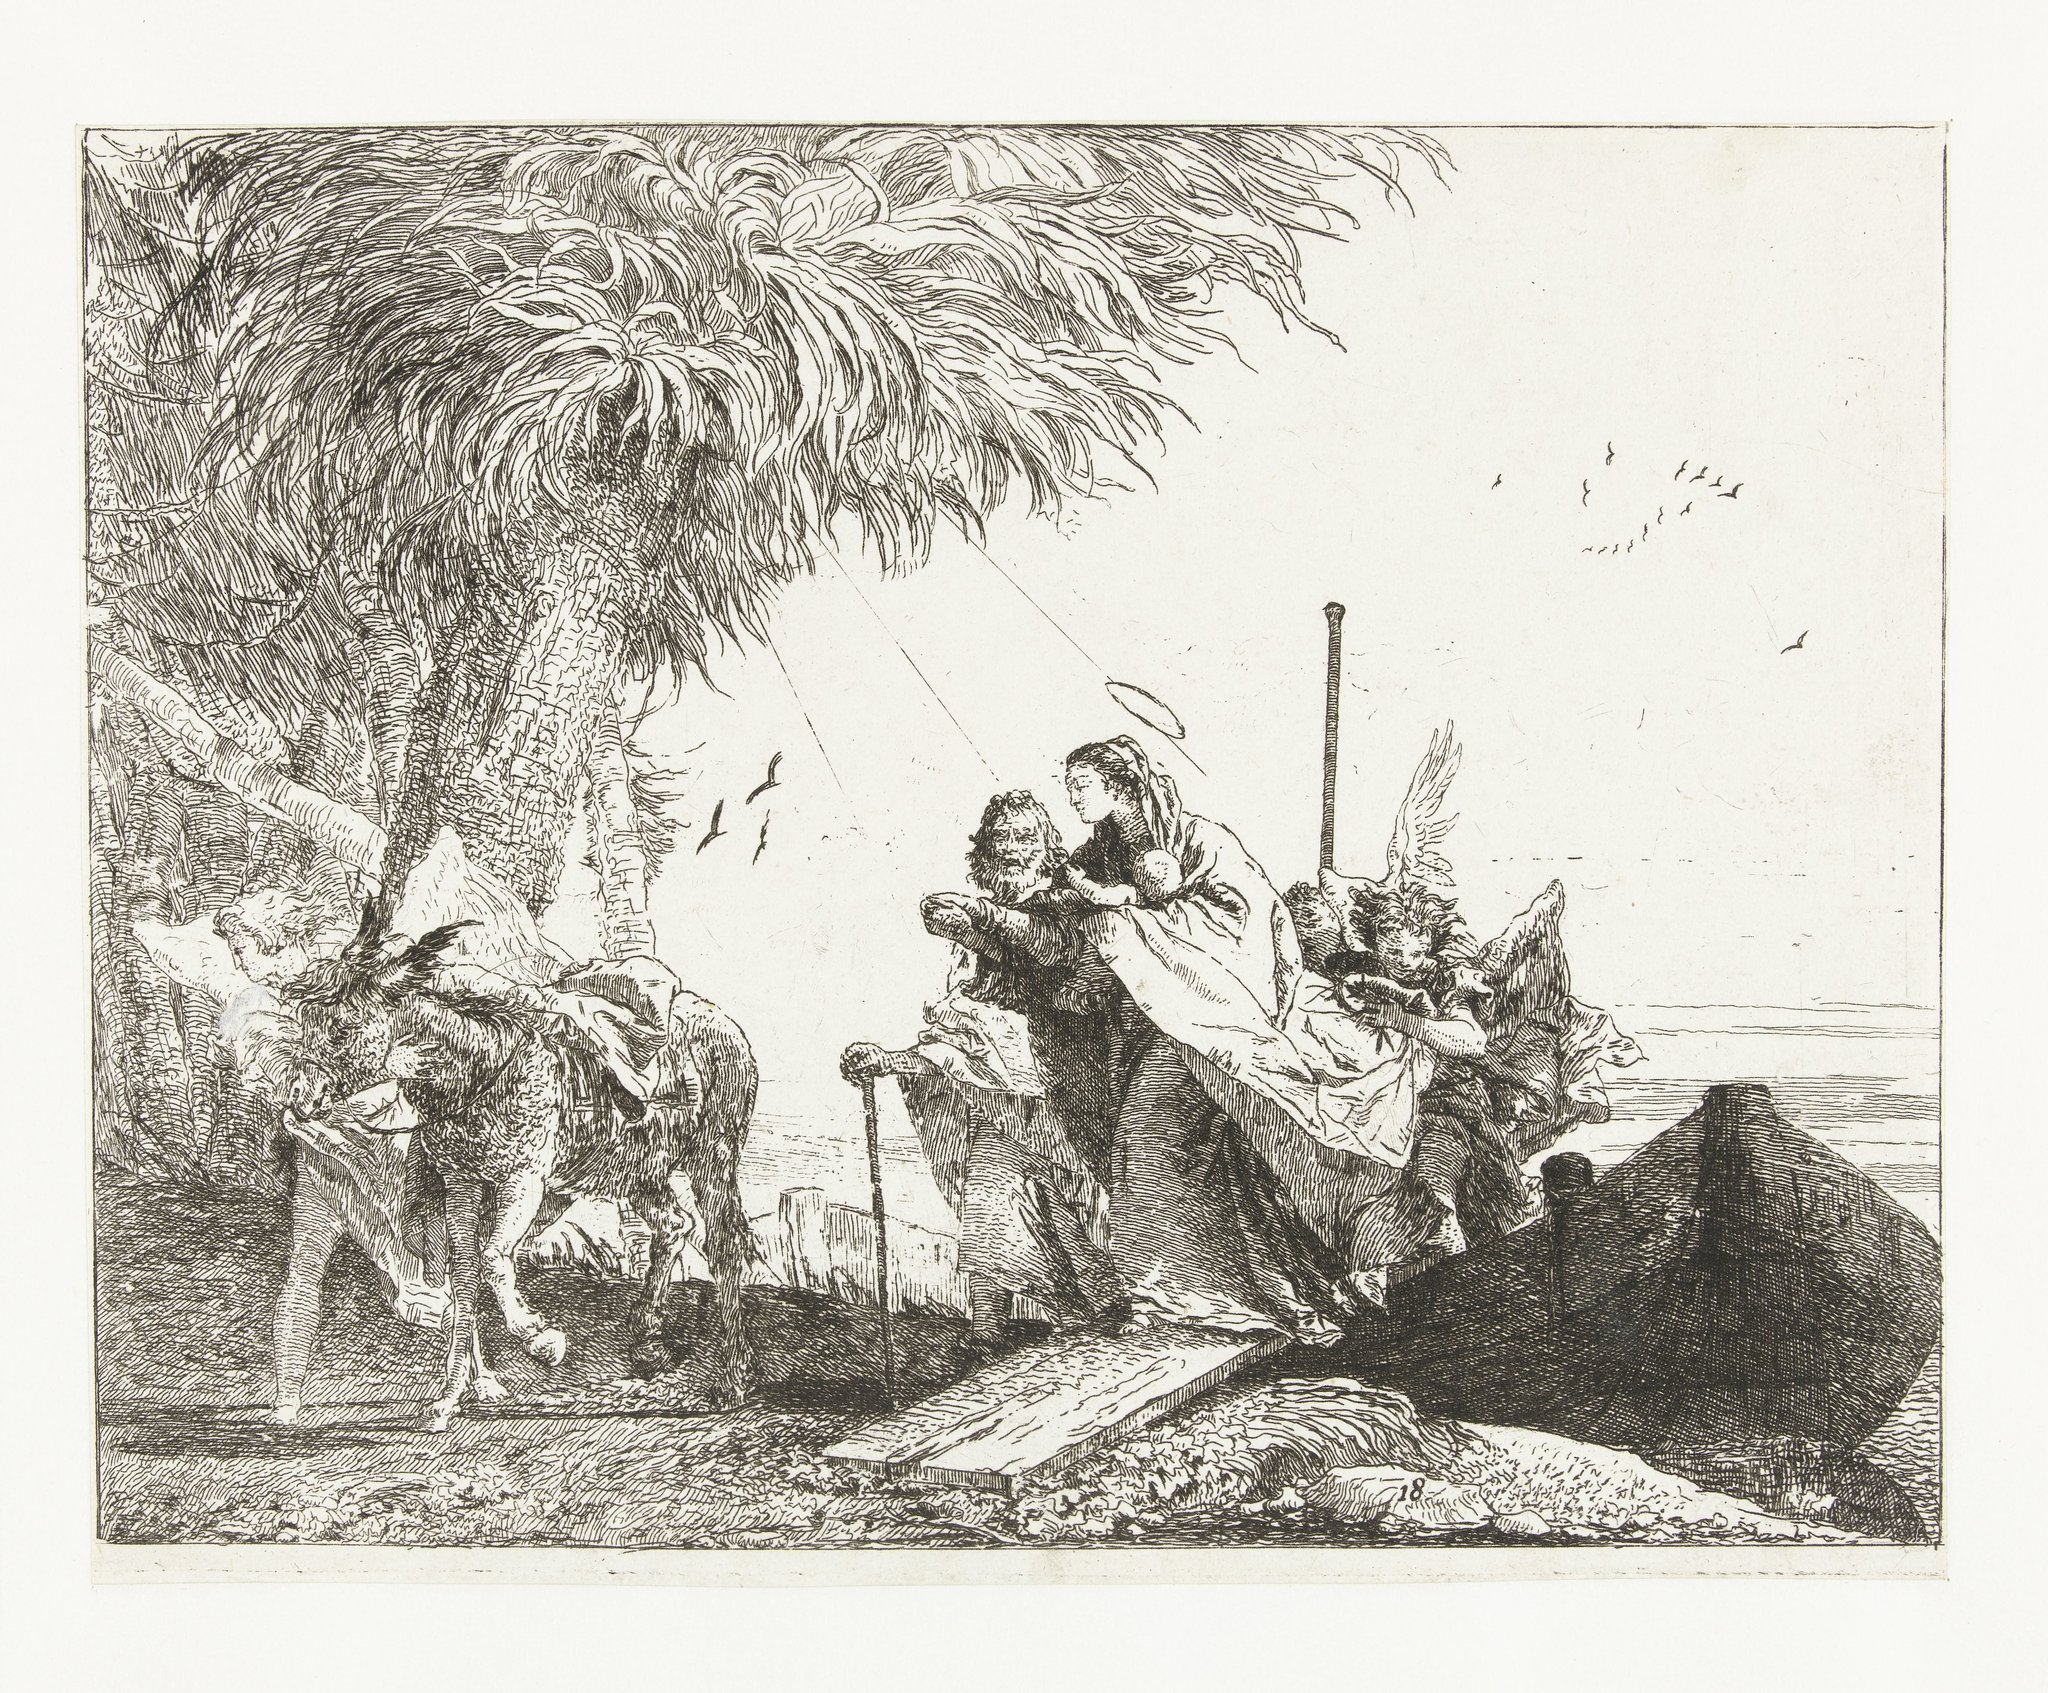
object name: print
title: Vlucht naar Egypte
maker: giovanni domenico tiepolo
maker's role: draughtsman, print maker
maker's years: 1727-1804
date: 1750-1753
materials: paper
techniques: etching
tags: flight into egypt and miracles during the journey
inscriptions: collector's mark: Lugt 2760, collector's mark: Lugt 2228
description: Prent uit serie van zevenentwintig prenten met de Vlucht naar Egypte.